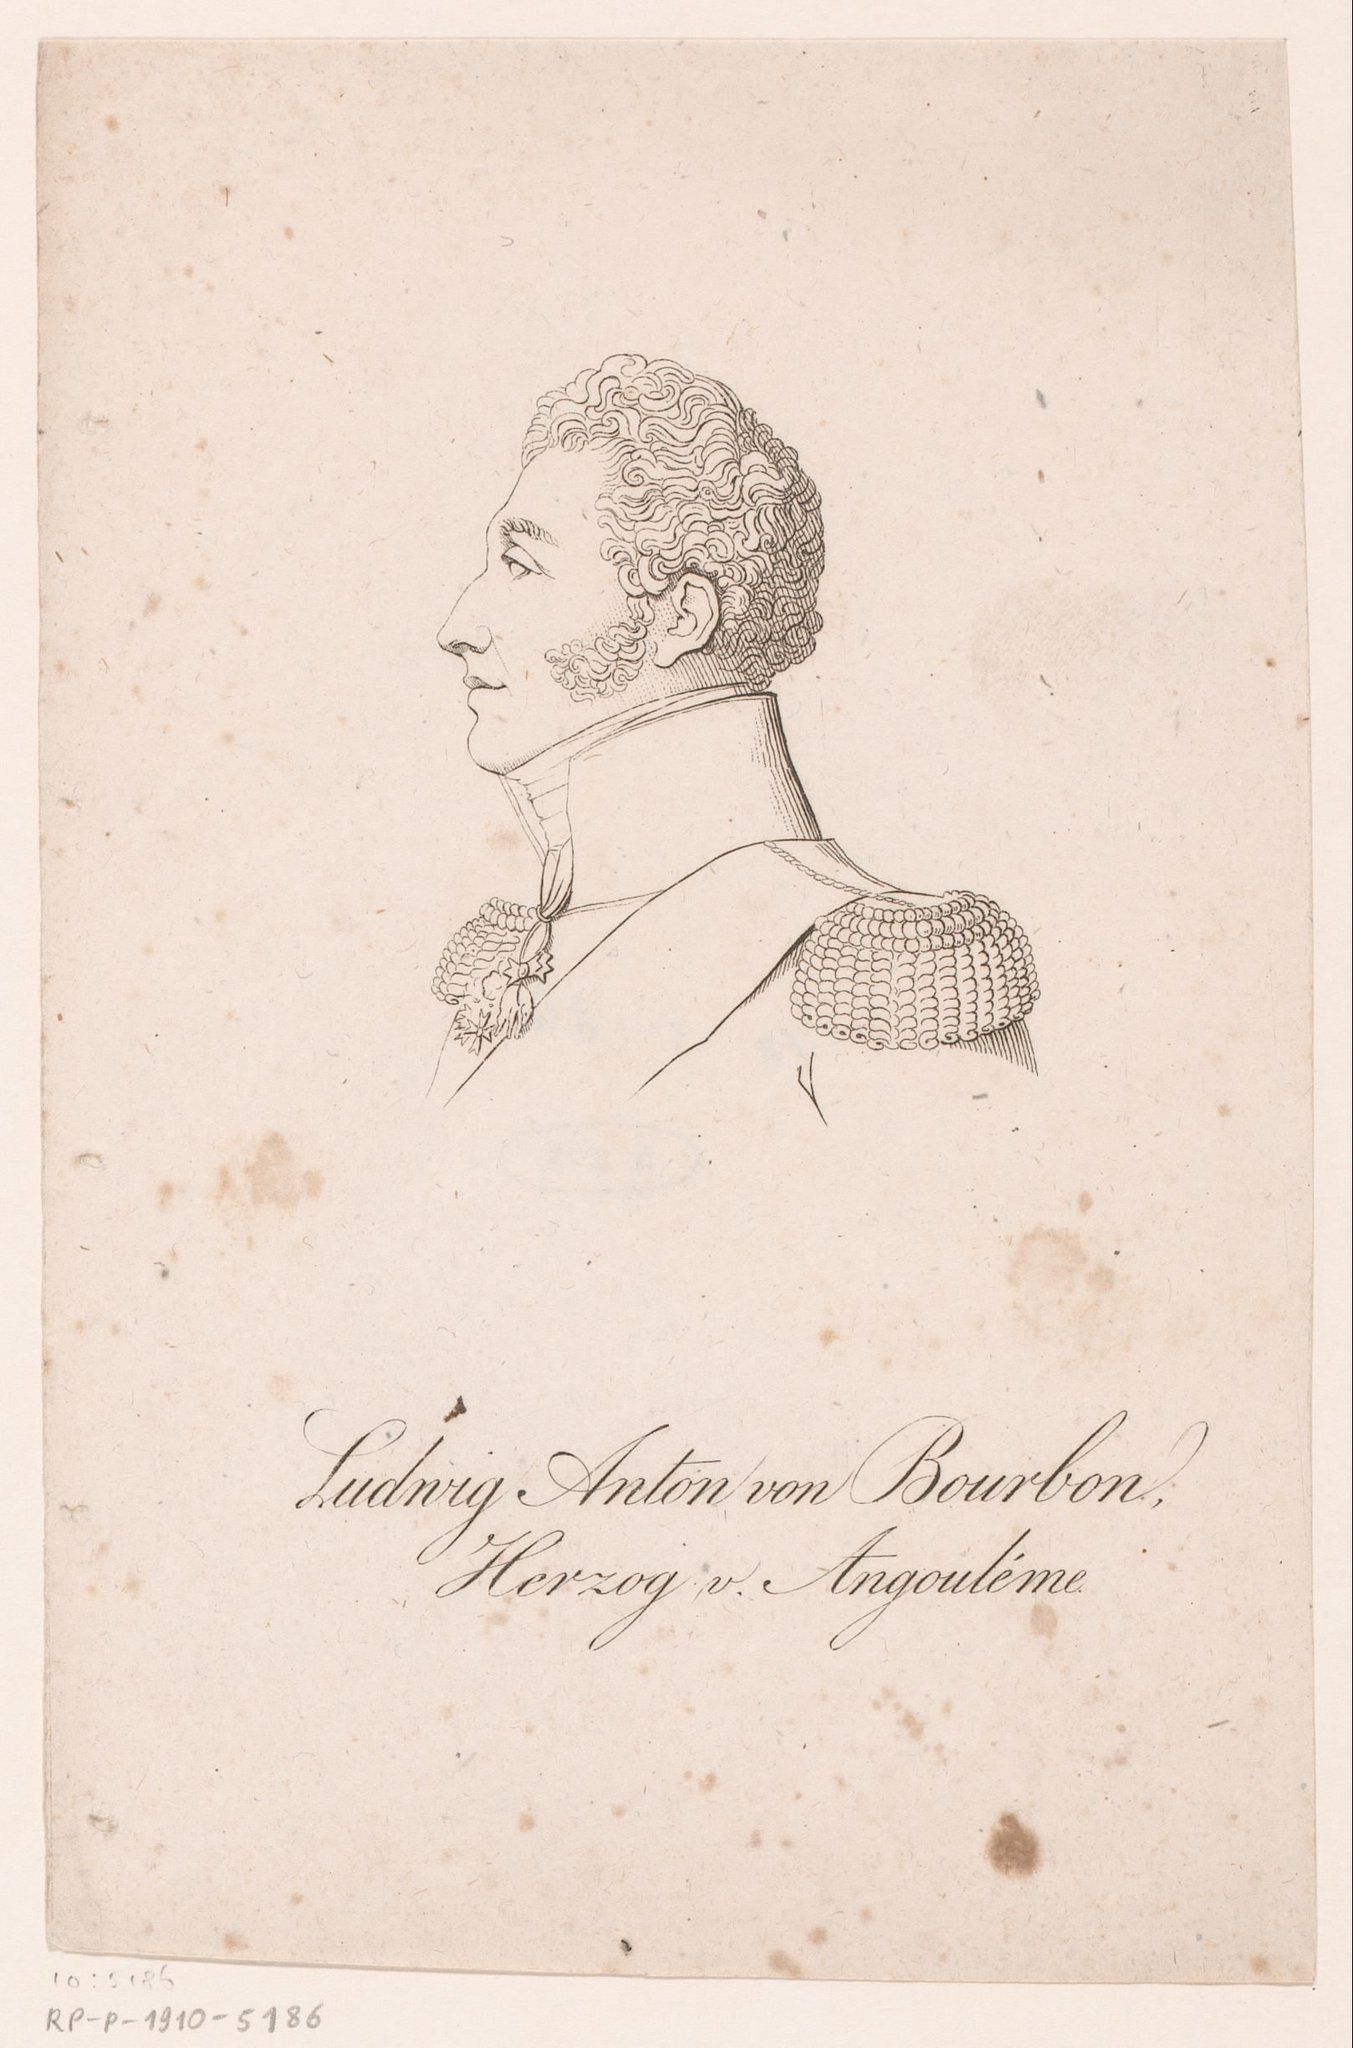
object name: book illustration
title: Portret van Lodewijk Anton van Bourbon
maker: jacques noël marie frémy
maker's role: print maker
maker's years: 1782-1867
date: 1815-1817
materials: paper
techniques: etching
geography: france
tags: historical persons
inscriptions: collector's mark: Lugt 2228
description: Mogelijk prent uit: Frémy, Jacques Noël Marie. Croquis de portraits des personnages remarquables dans tous les genres, dessinés et gravés. Parijs: Jacques Noël Marie Frémy, 1815-1817.